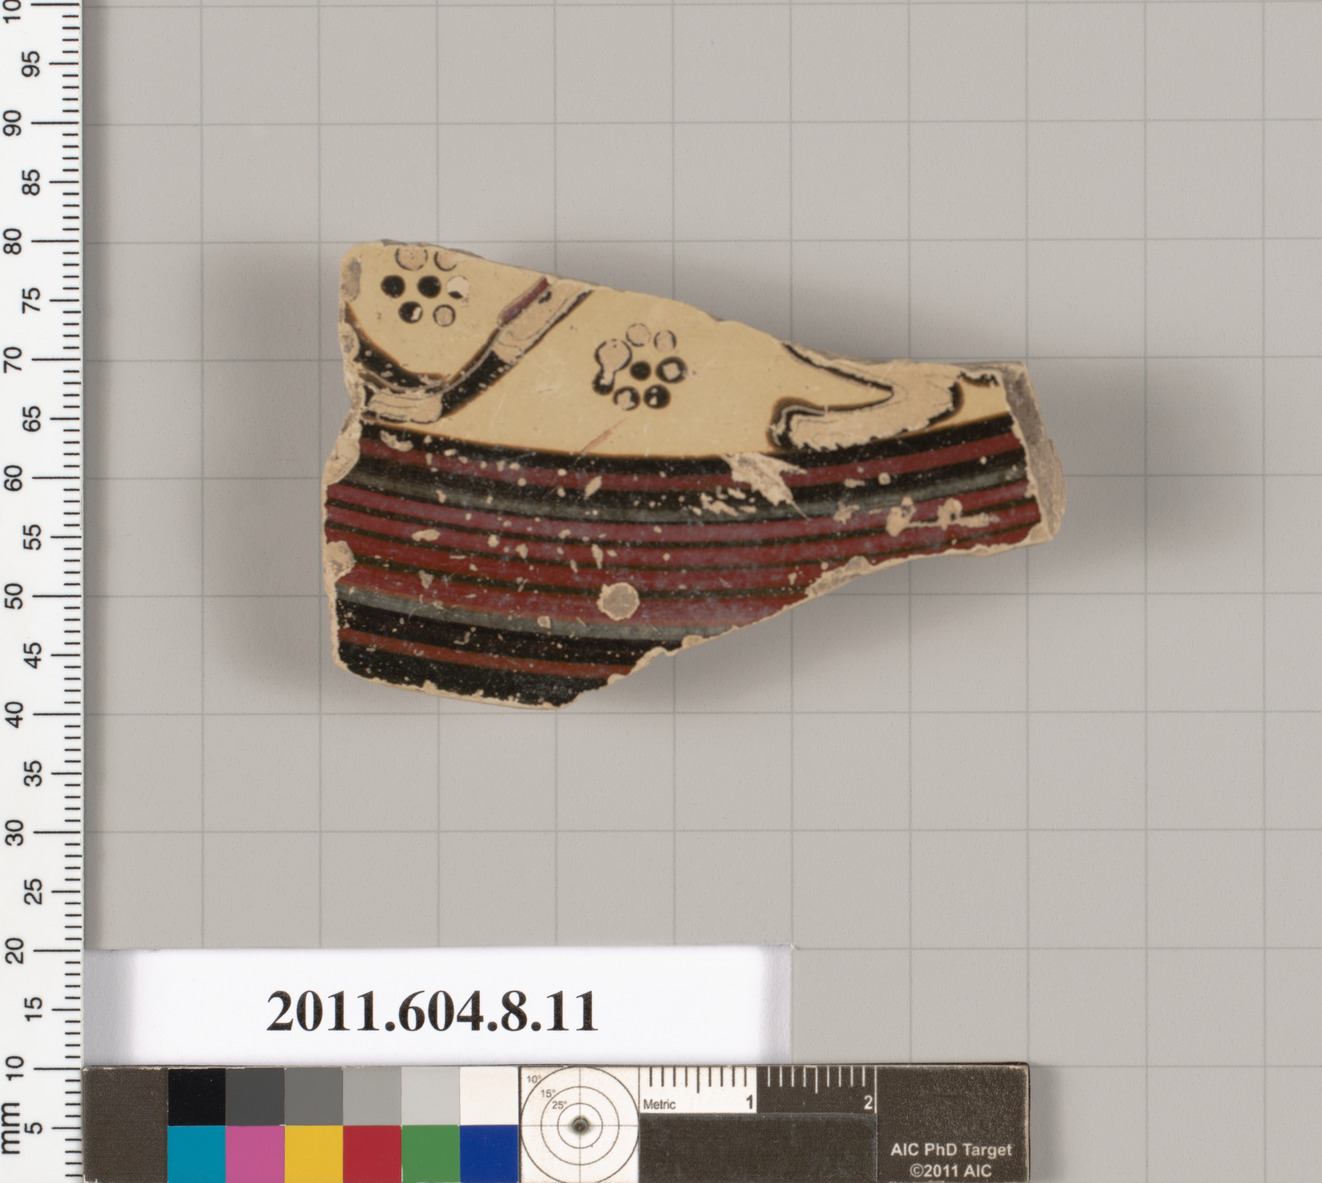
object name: lid fragment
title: Terracotta fragment of a lid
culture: greek, corinthian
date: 567-535 BCE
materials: terracotta